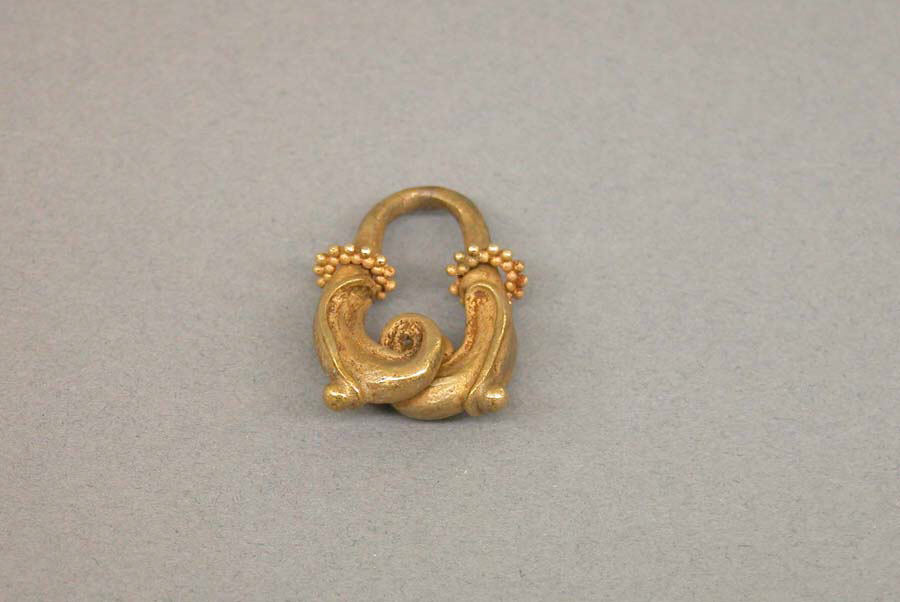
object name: ear ornament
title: Ear Ornament with Granulate Design and Foliate Motif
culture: indonesian, javanese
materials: gold